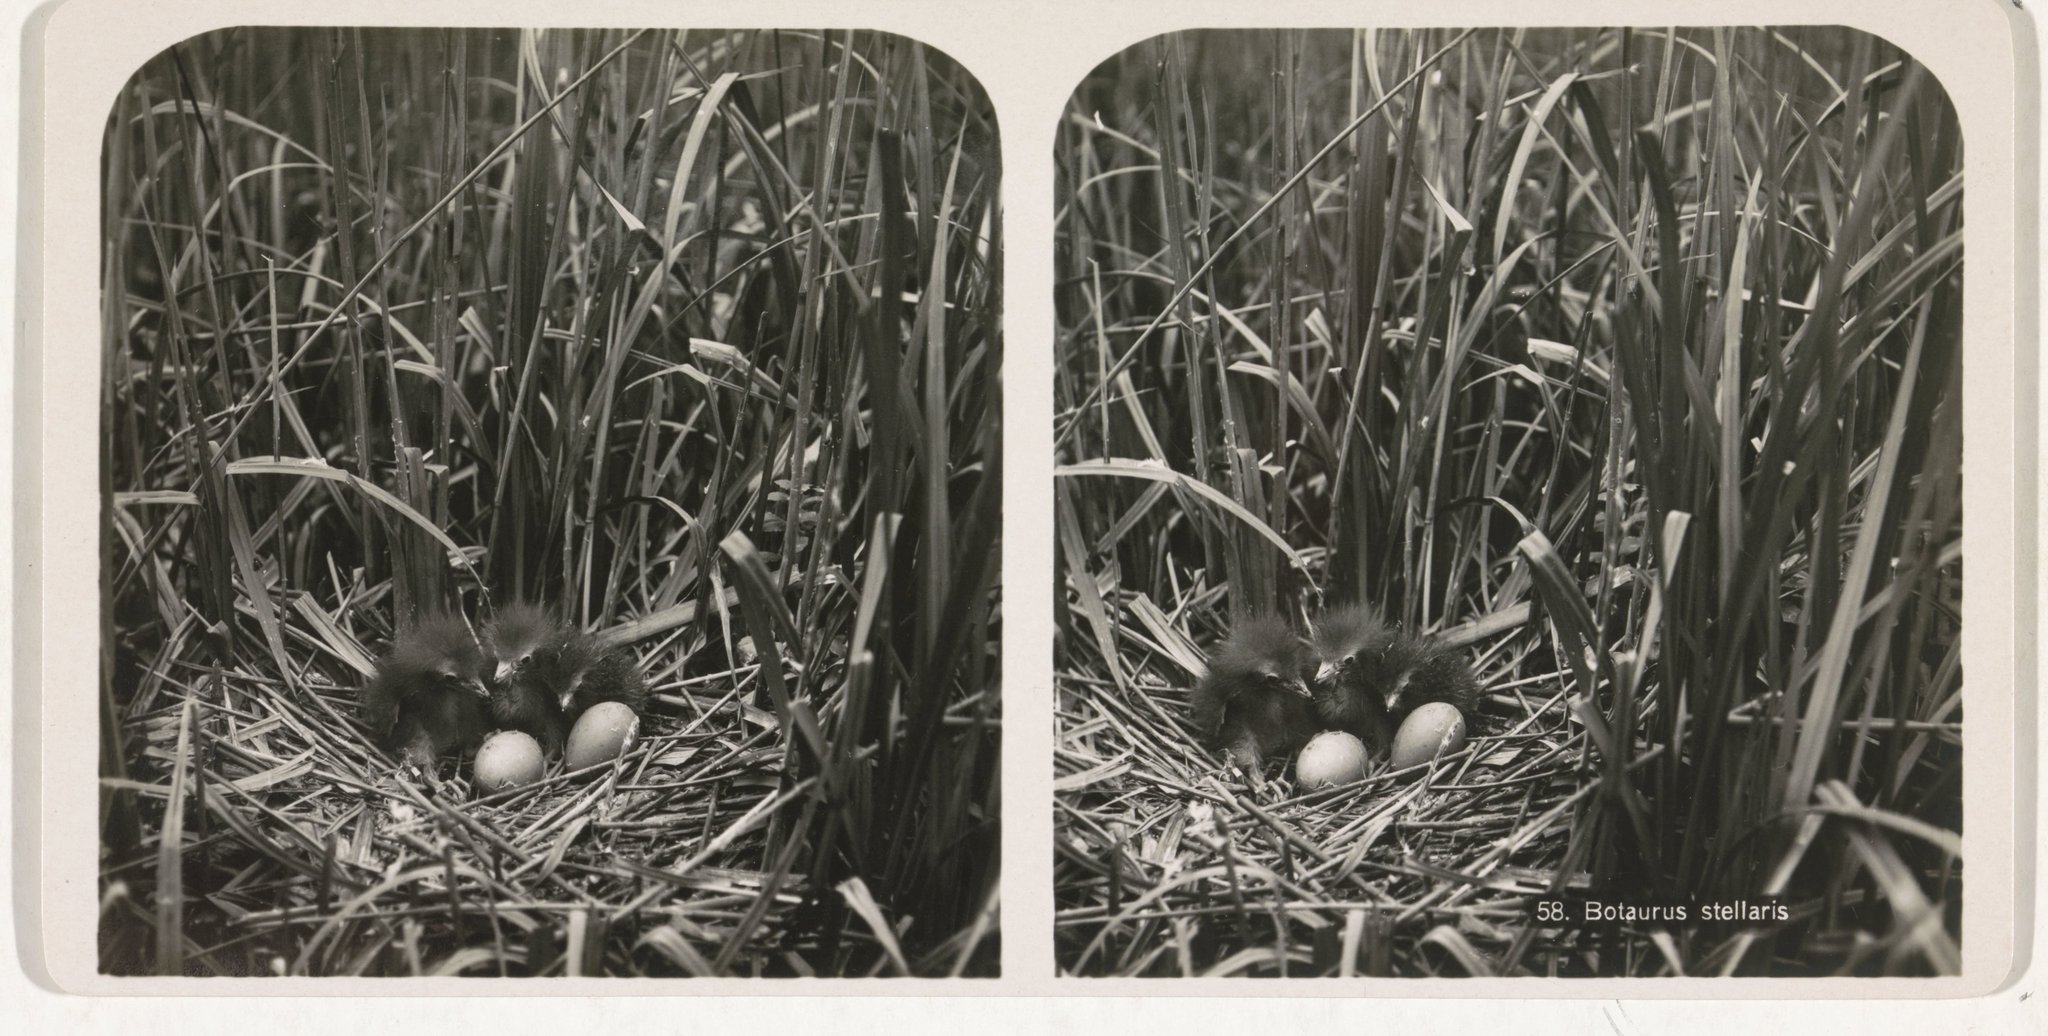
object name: stereograph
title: 58. Botaurus stellaris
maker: adolphe burdet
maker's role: fotograaf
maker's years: 1860-1940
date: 1870-1940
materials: photographic support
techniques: gelatin silver print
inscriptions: label: ‘Roerdomp’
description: De foto is afkomstig uit een serie van 12 stereofoto's met moerasvogels die bewaard worden in het originele mapje. Bij dit mapje zit ook een blaadje met gedrukte tekst over de vogels.